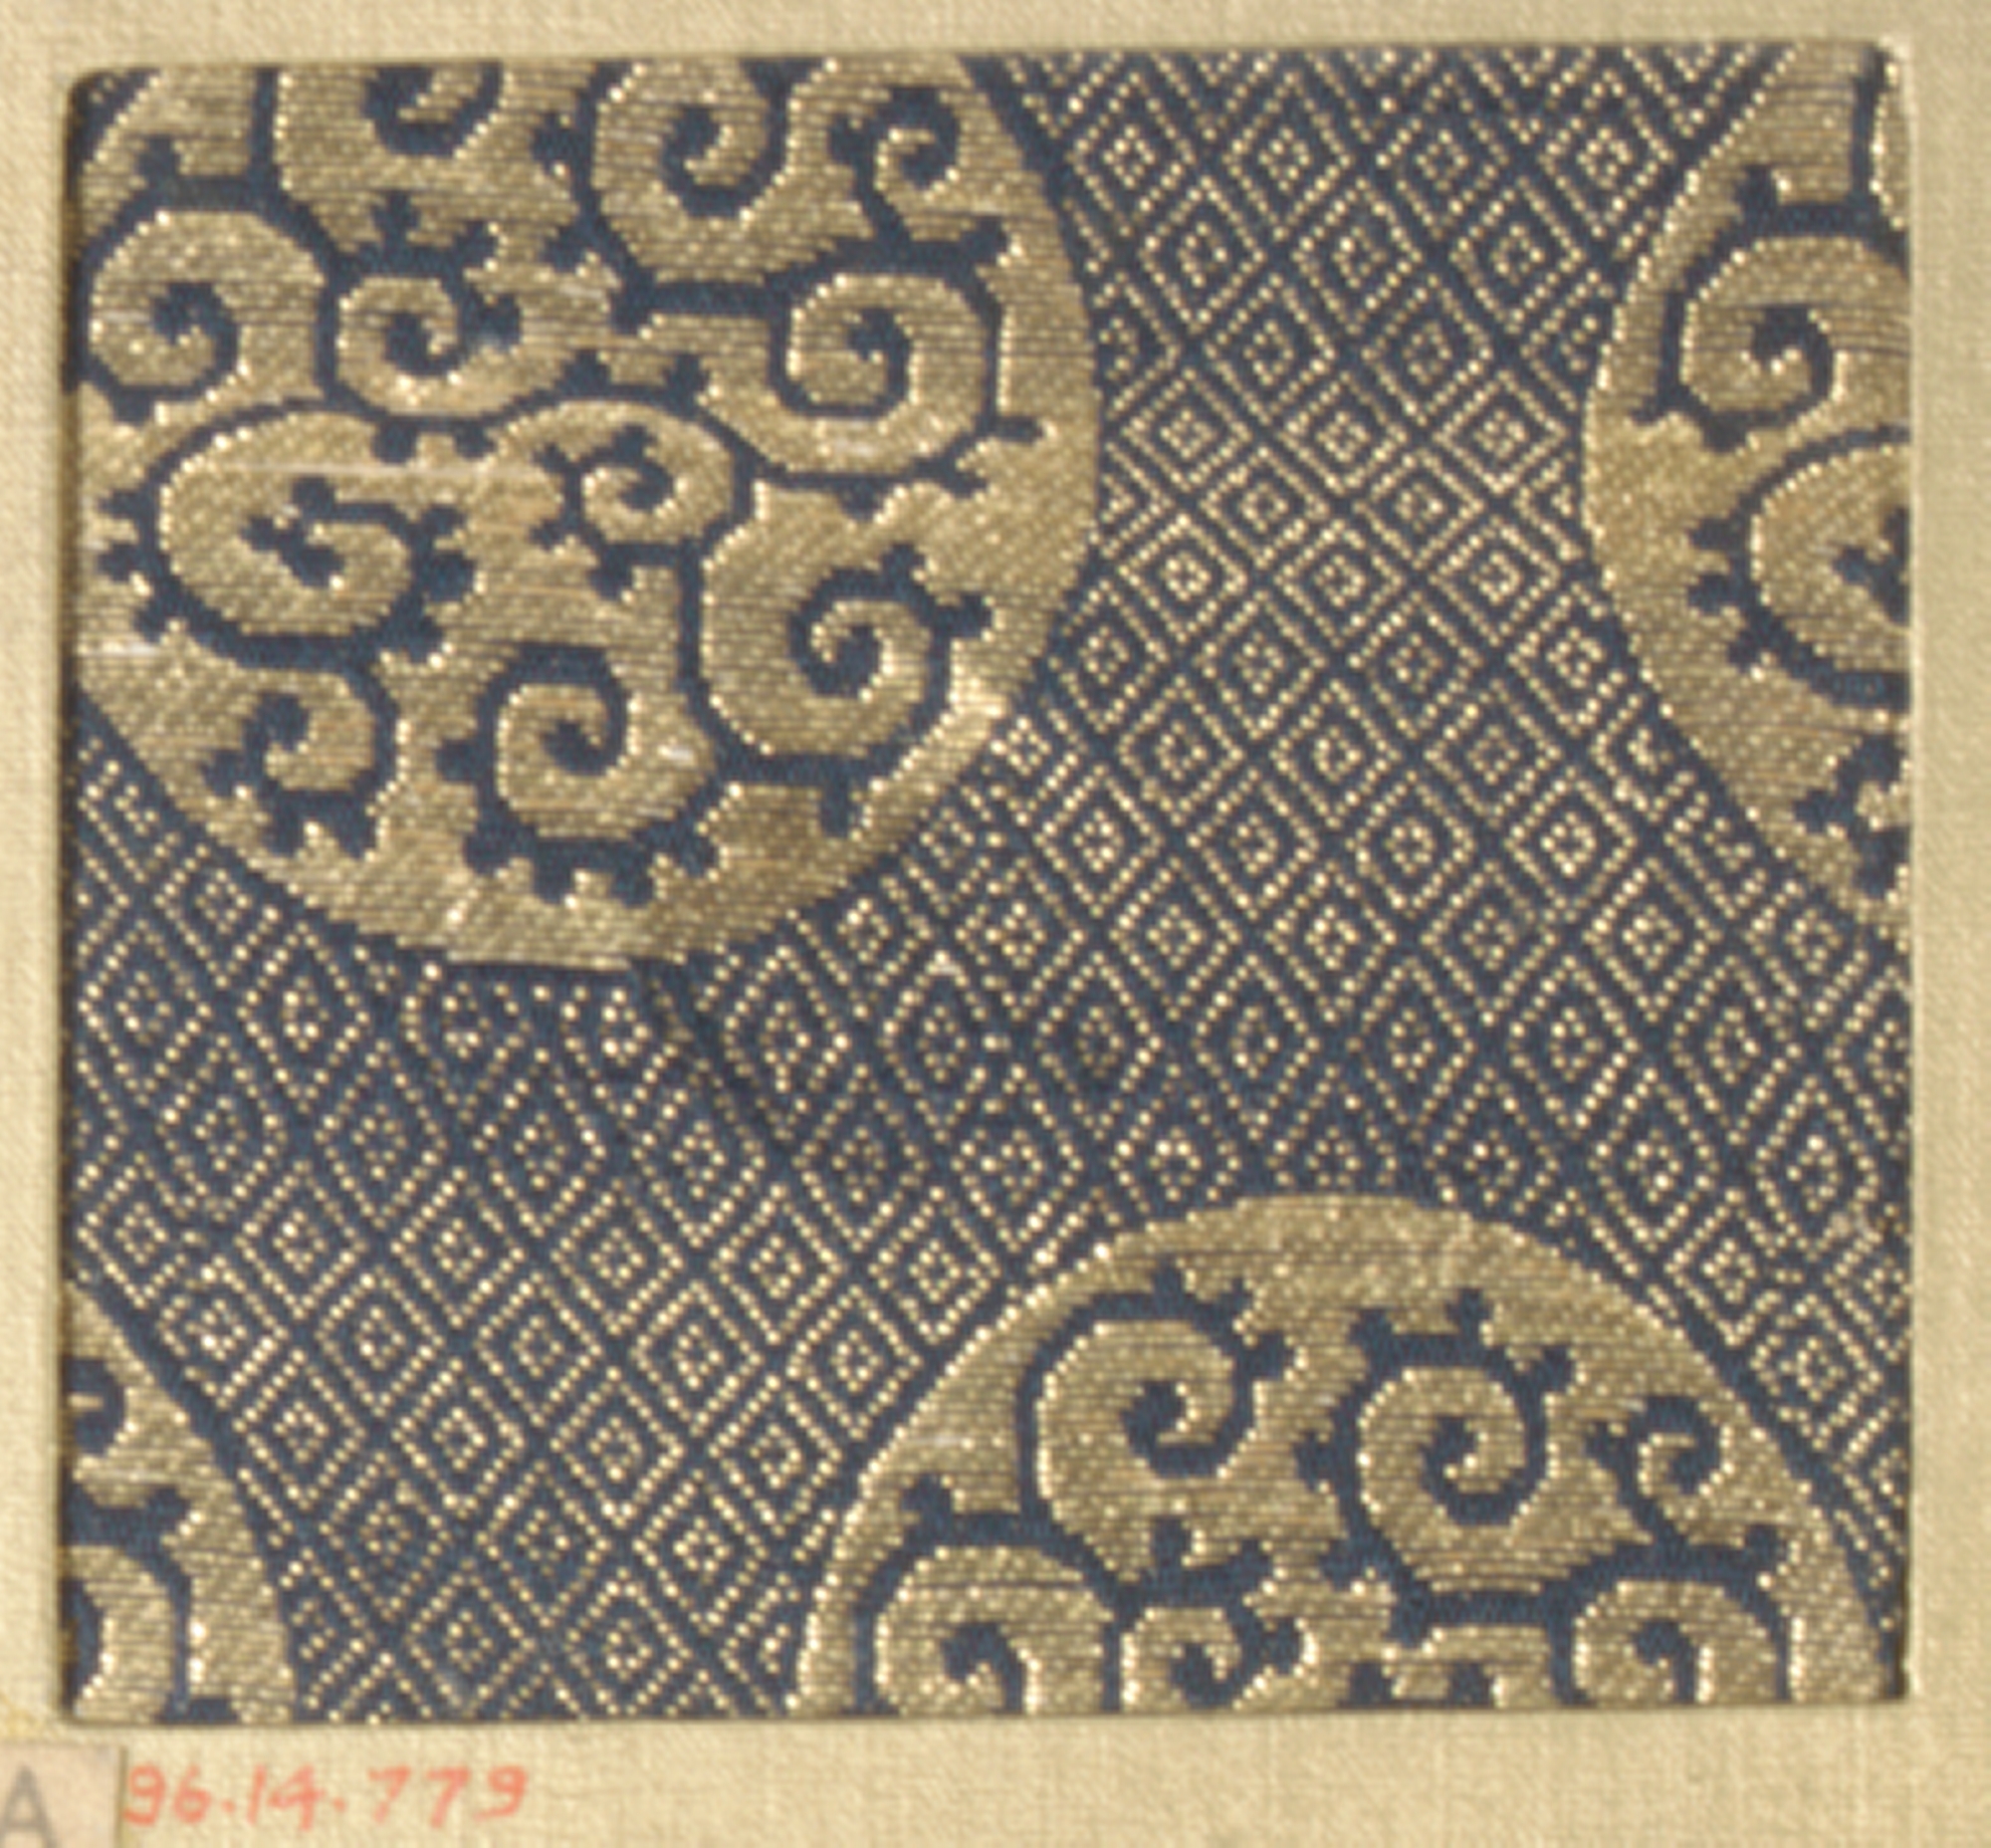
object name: piece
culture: japanese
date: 1701-1900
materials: silk